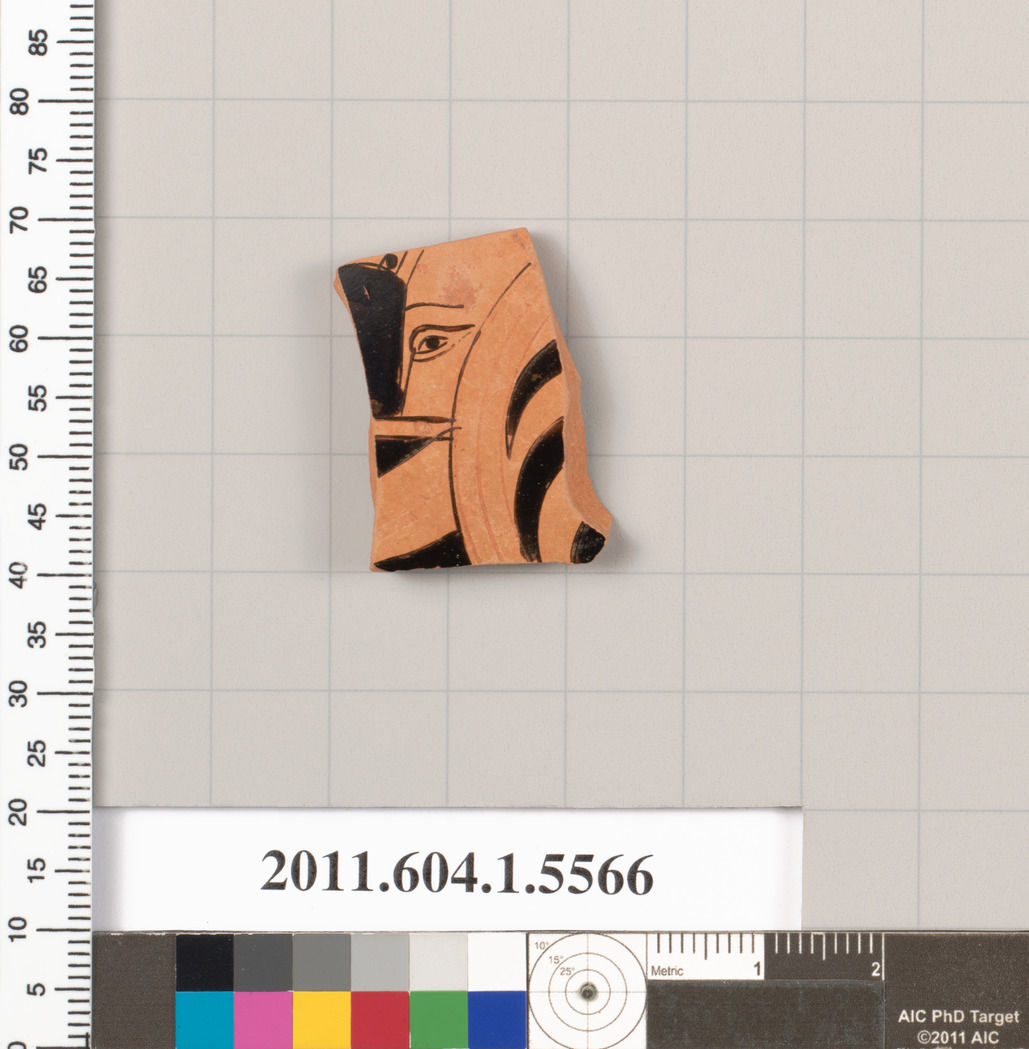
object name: kylix fragment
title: Terracotta fragment of a kylix (drinking cup)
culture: greek, attic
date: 520-510 BCE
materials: terracotta